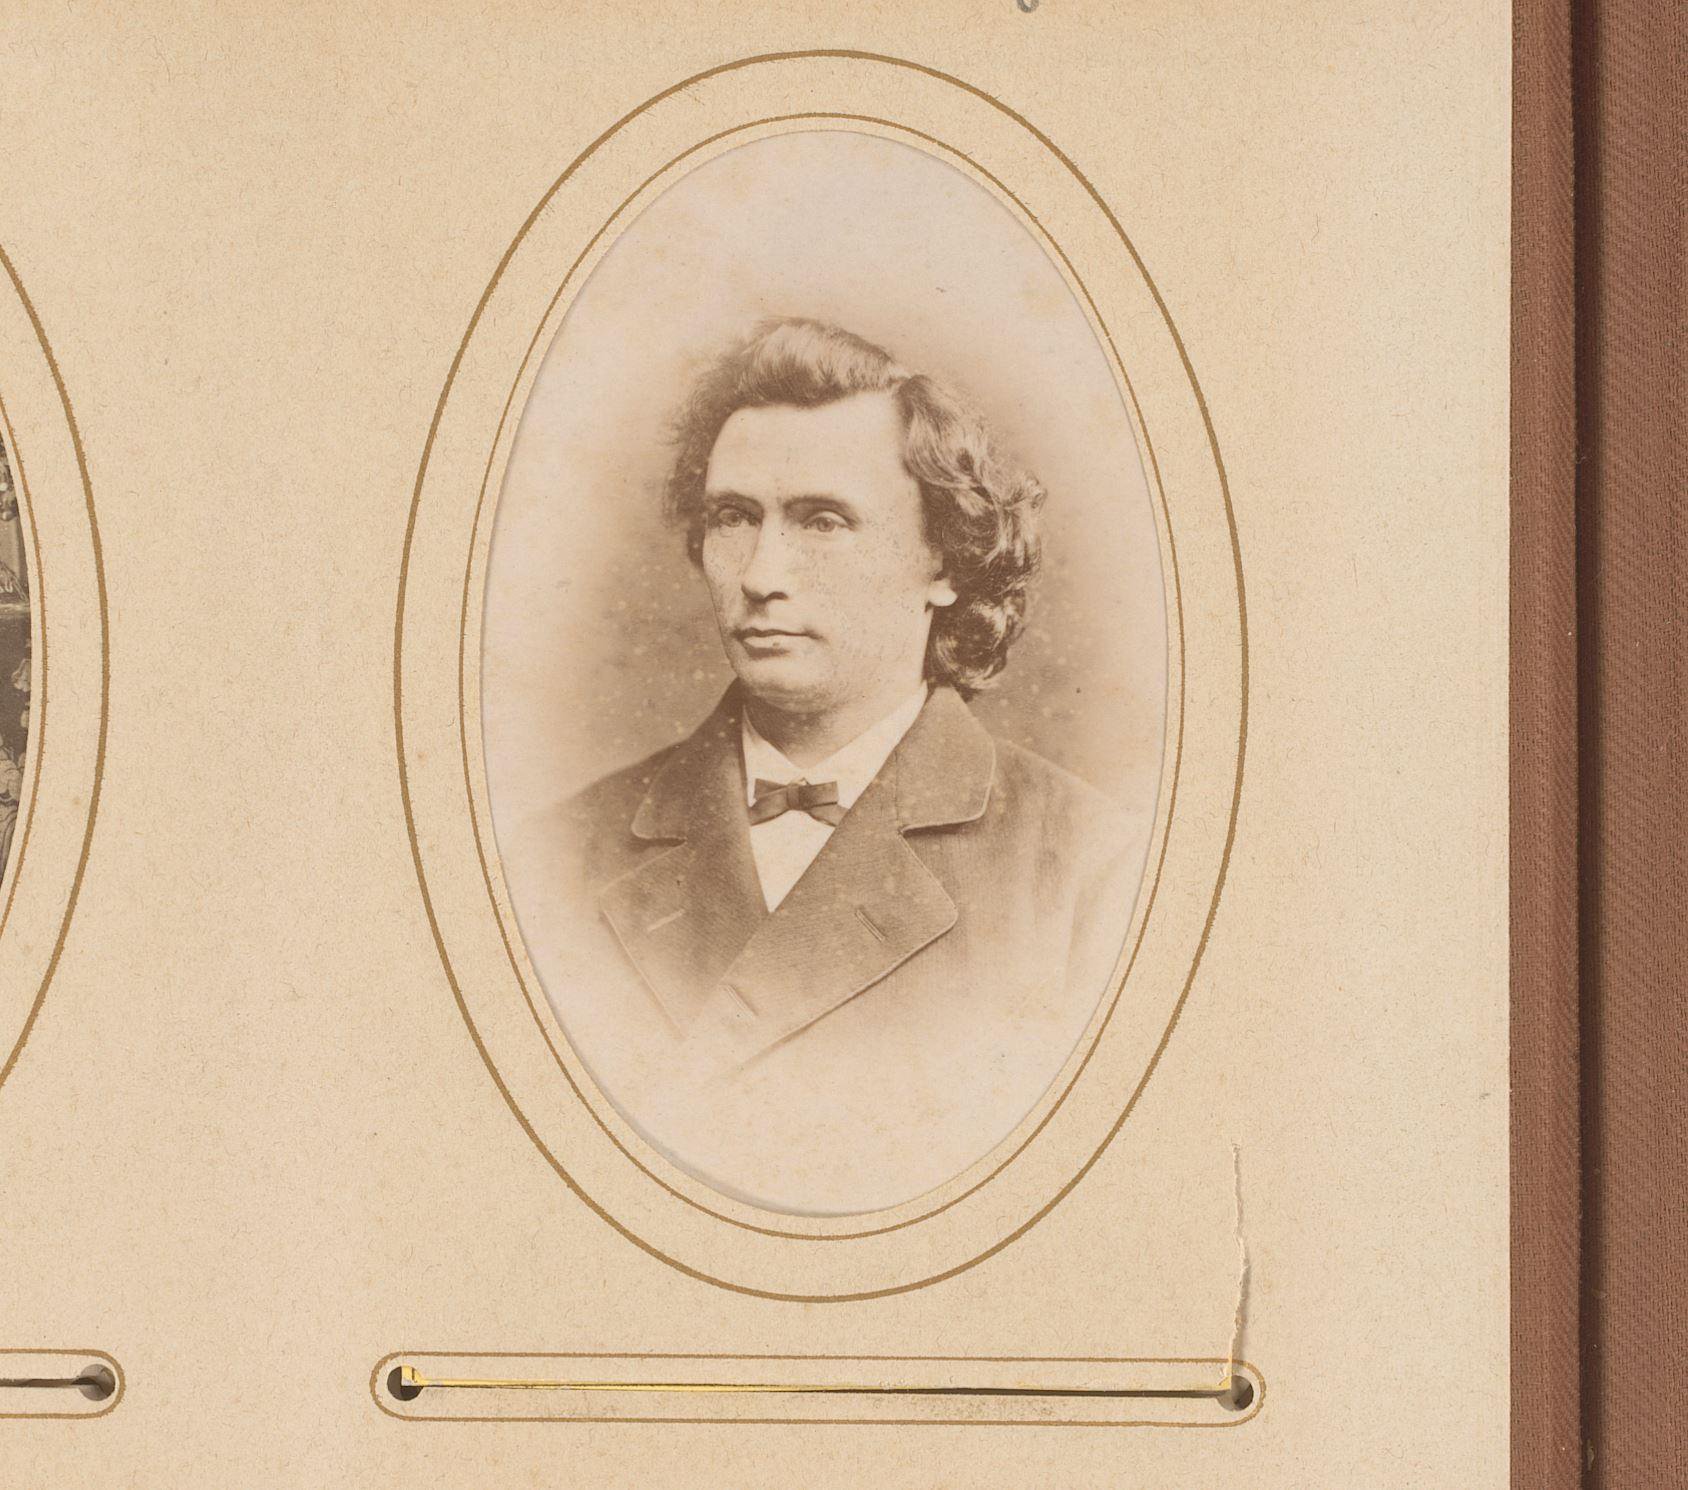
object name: photograph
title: Portret van een man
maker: friedrich julius von kolkow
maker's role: fotograaf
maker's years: 1839-1914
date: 1879-1900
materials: cardboard, photographic support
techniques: albumen print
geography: groningen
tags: historical persons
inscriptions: inscription: ‘Philadelphia 1876/ 1879/ Fr. Jul. von Kolkow/ Hof-Photograph/ Z.K.H. Prins Hendrik der Nederlanden/ Groningen’